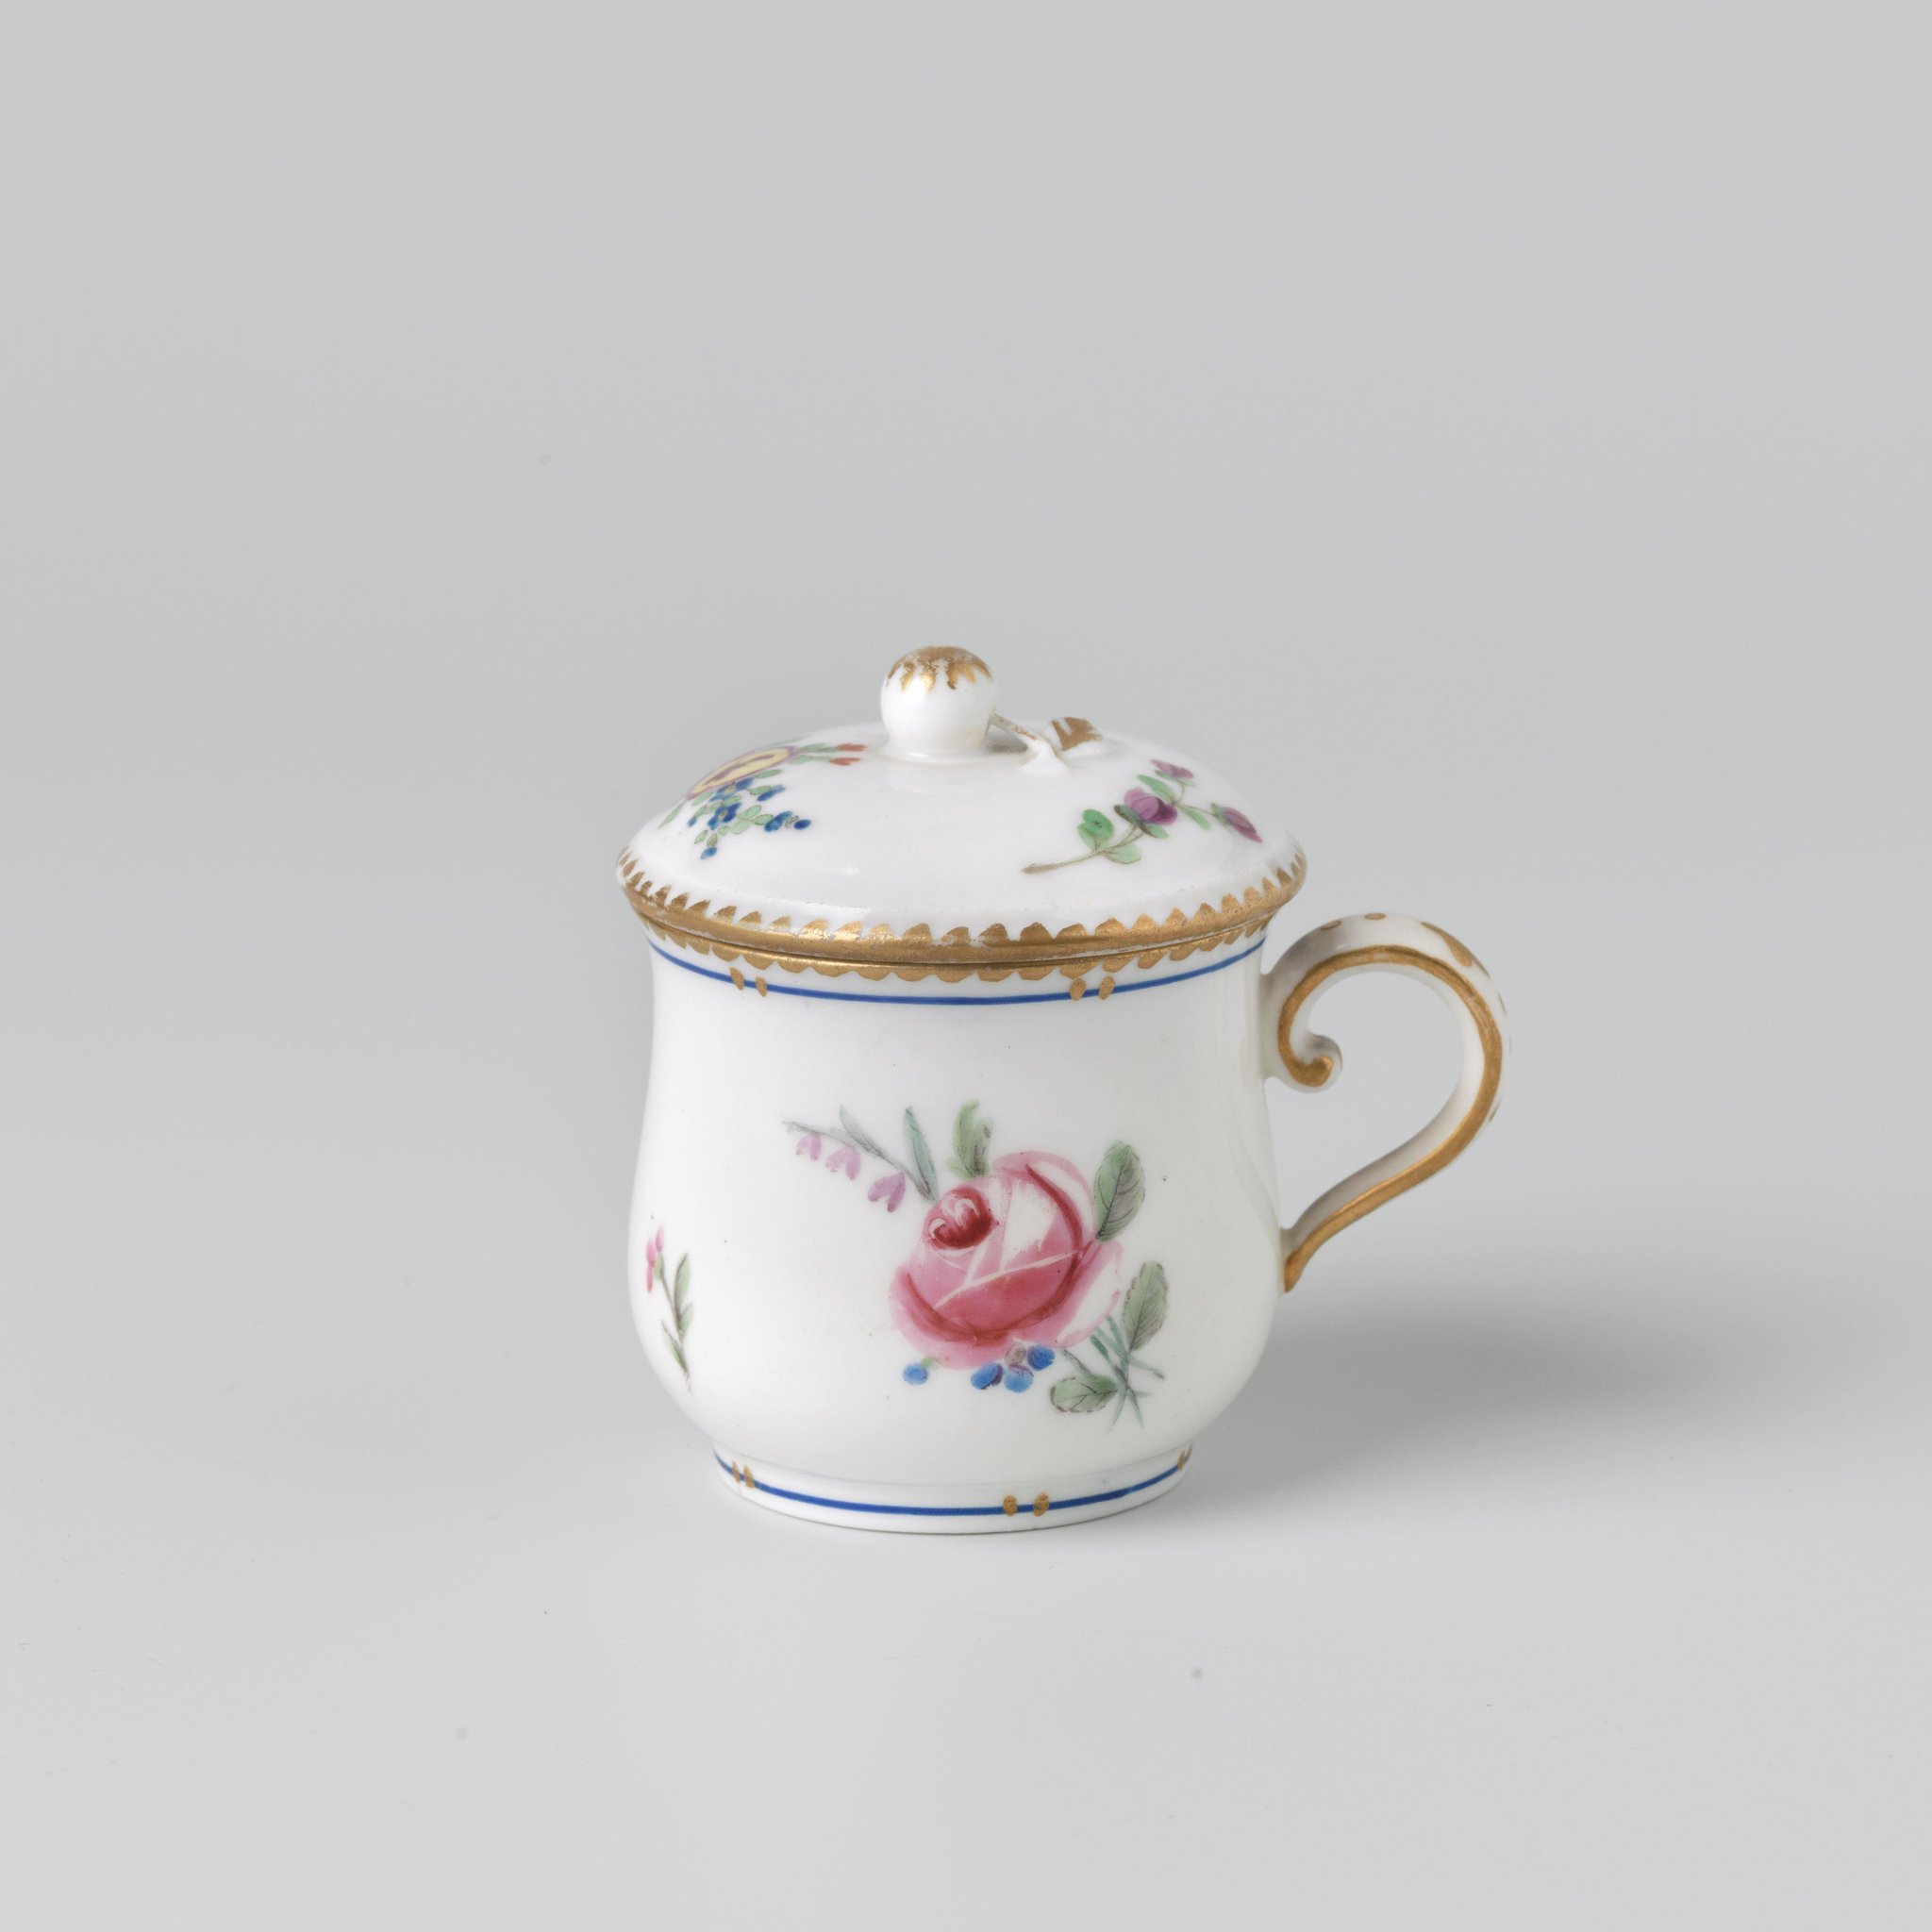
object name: roompot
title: Pot with bouquets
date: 1787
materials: glaze, gold, paint, porcelain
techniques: firing, forming, gilding, turning, vitrification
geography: sèvres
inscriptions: mark: ‘dubbele L/ jaarnummer ii/ N’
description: Pot (roompot) van porselein met een licht peervormig lichaam en gekruld oor, beschilderd op het glazuur in blauw, rood, roze, groen, geel, paars, zwart en goud. De buik is versierd met verschillende boeketten en strooibloemen. De voet en rand met een blauwe lijn, onderbroken door telkens tweemaal een schuin gouden streepje. Op de rand boven deze lijn een gouden band van halve bollen. Gemerkt op de onderzijde met de dubbele L met jaarletter ii, waaronder een N.